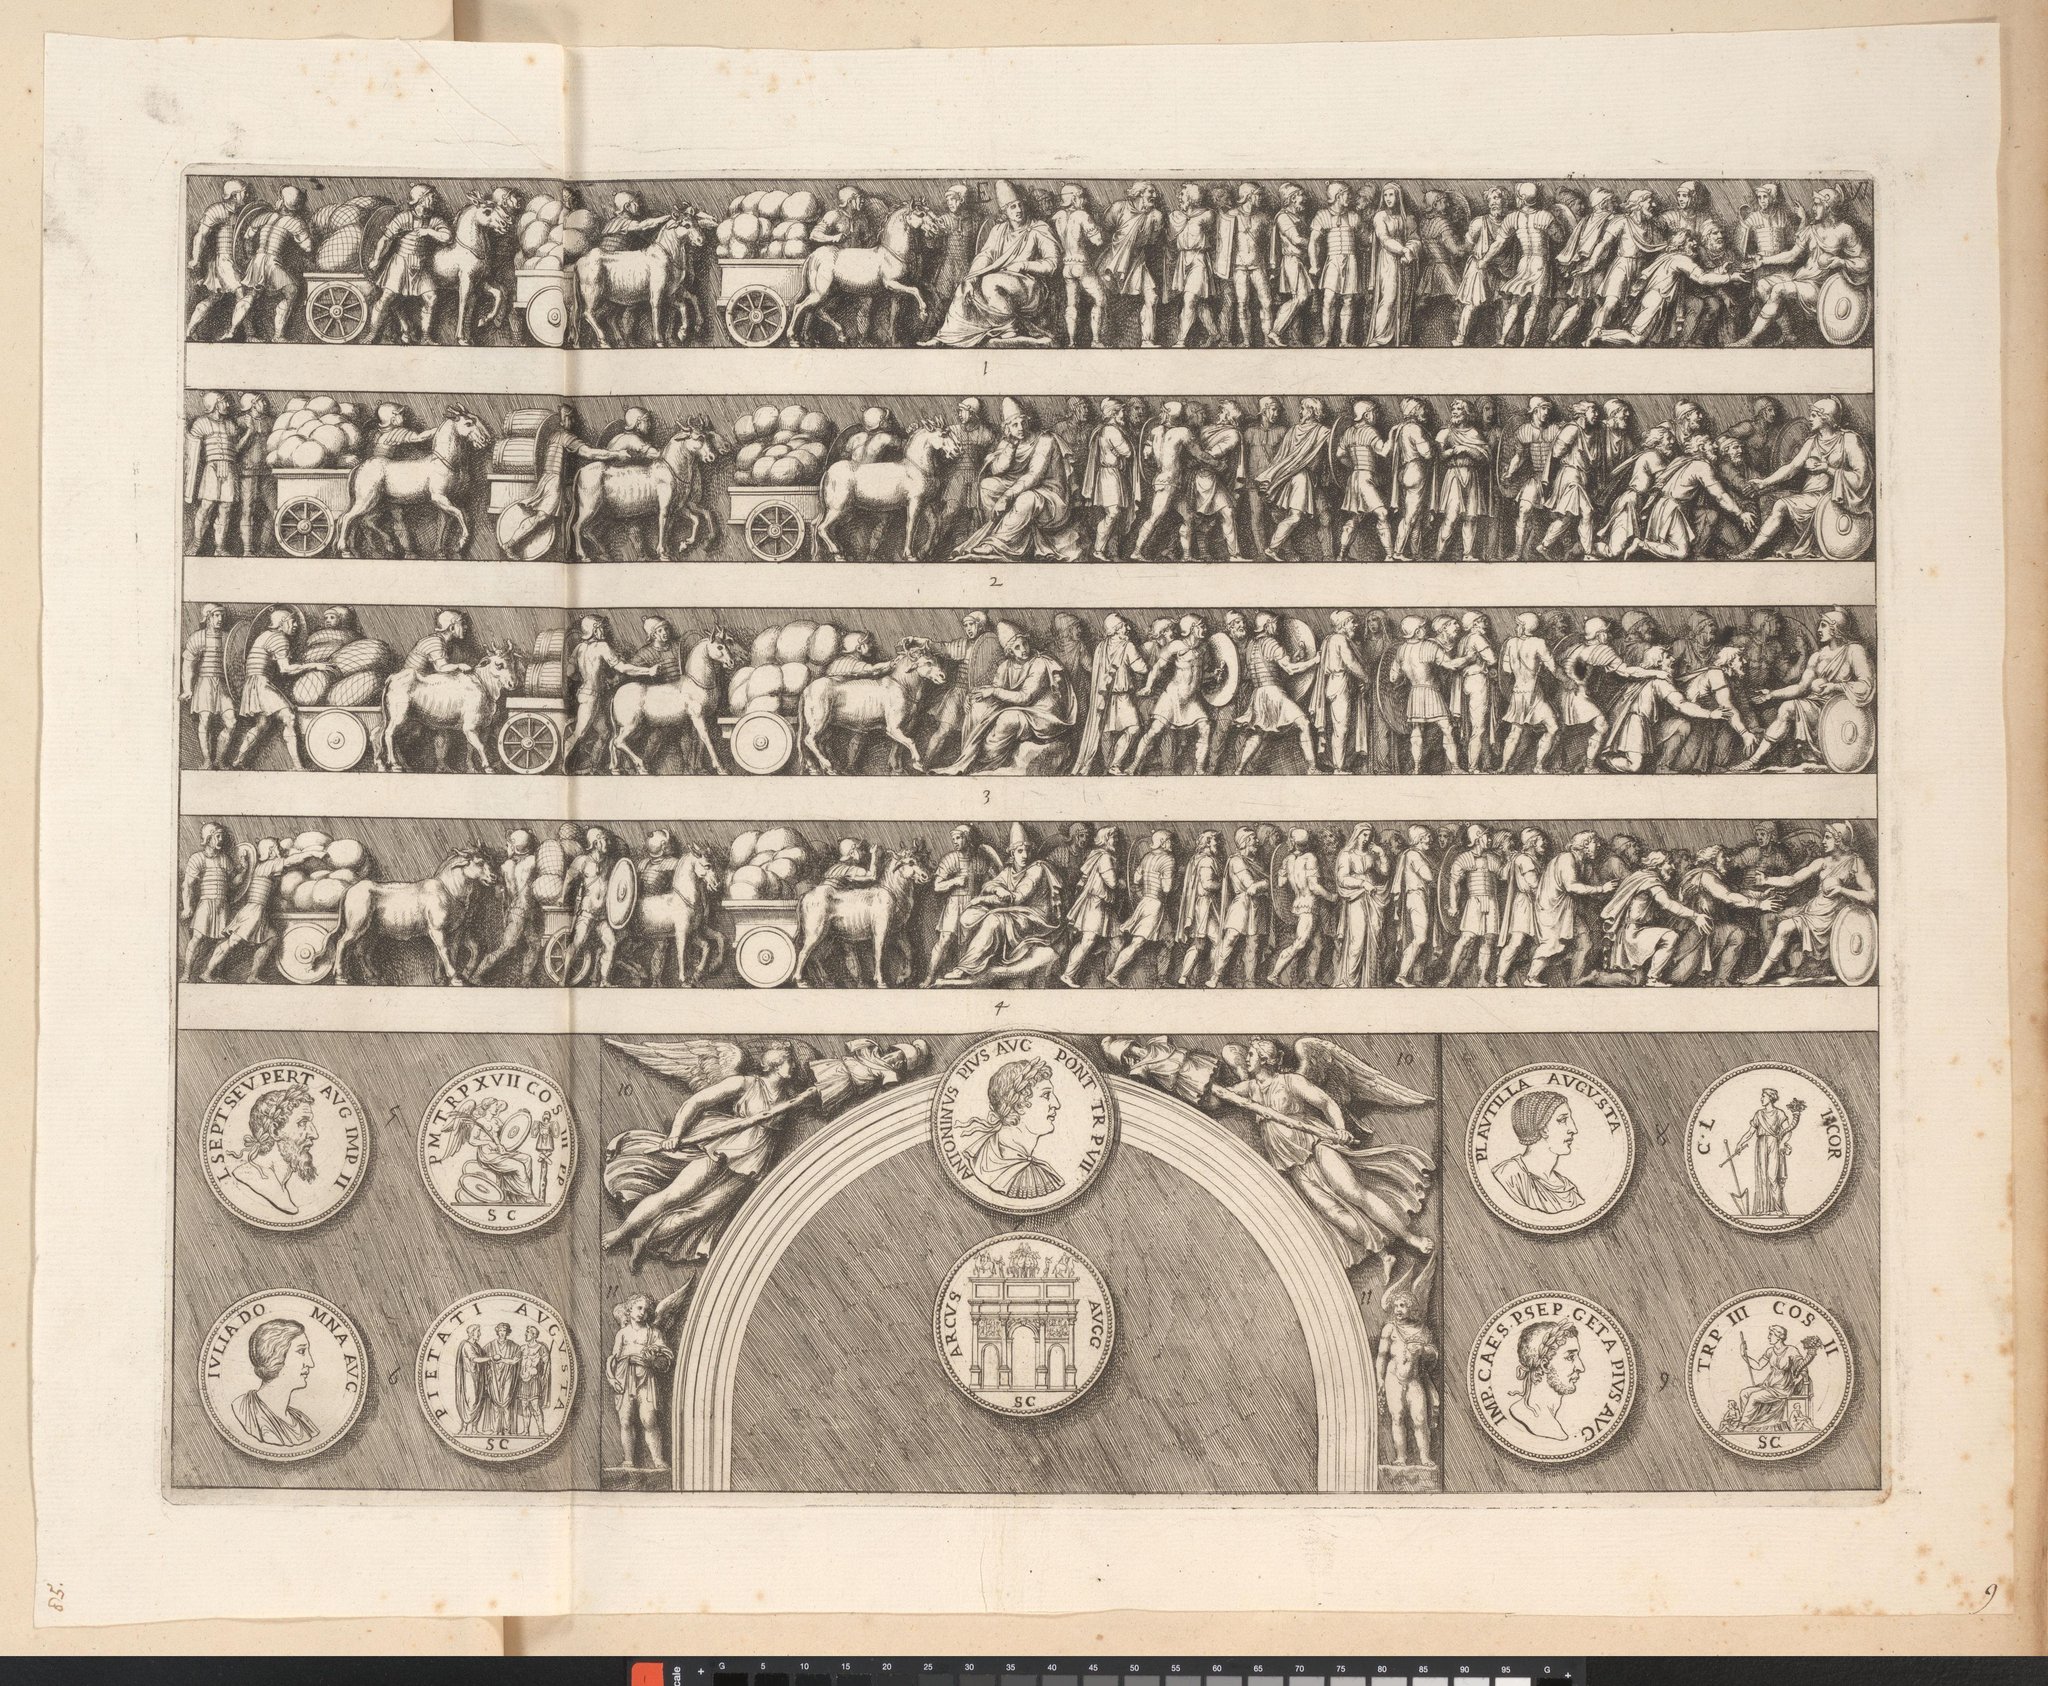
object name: album leaf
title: Reliëfs op de Boog van Septimius Severus te Rome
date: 1676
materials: paper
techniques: etching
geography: rome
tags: triumphal arch, medal (considered as a piece of sculpture, regardless of its specific function), piece of sculpture, reproduction of a piece of sculpture, horse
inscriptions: number: ‘85’, number: ‘9’, number: ‘41’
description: Vier friezen met reliëfs op de Boog van Septimius Severus en daaronder tien penningen. Middenboven: E. Genummerd rechtsboven: VI. Prent maakt deel uit van een album.